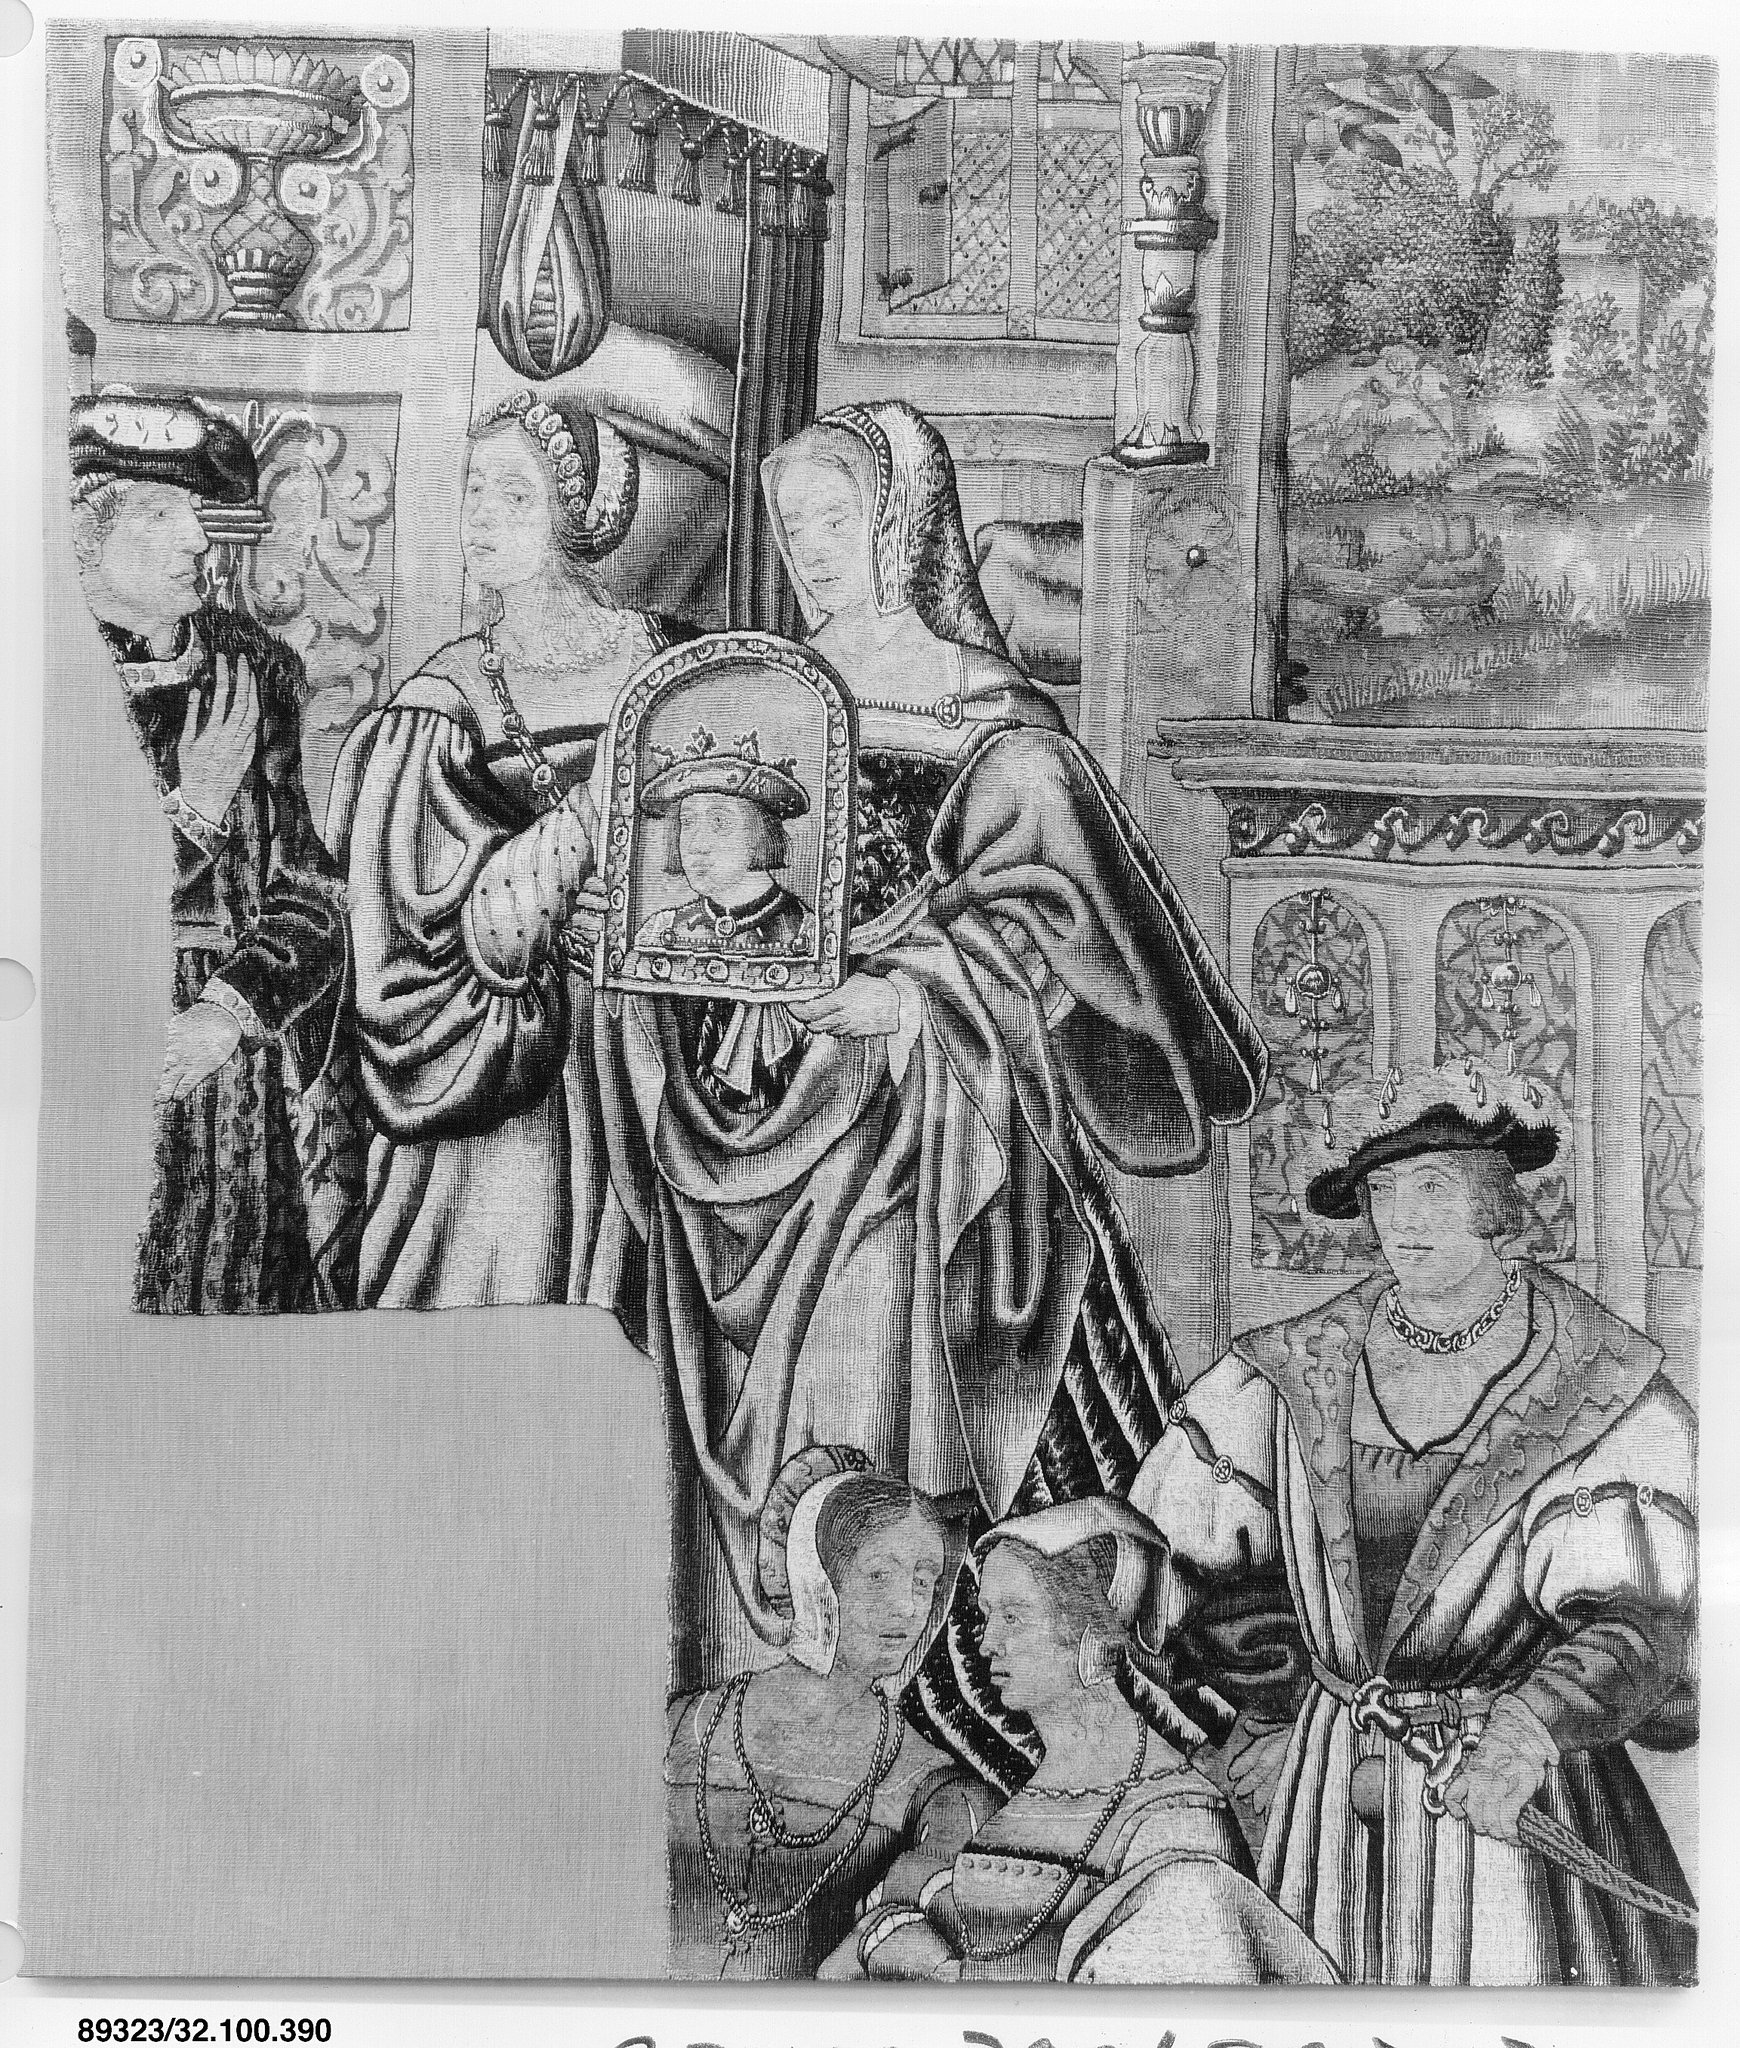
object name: tapestry fragment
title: Interior scene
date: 1520-1525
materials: silk, wool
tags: swords,men,portraits,women,trees